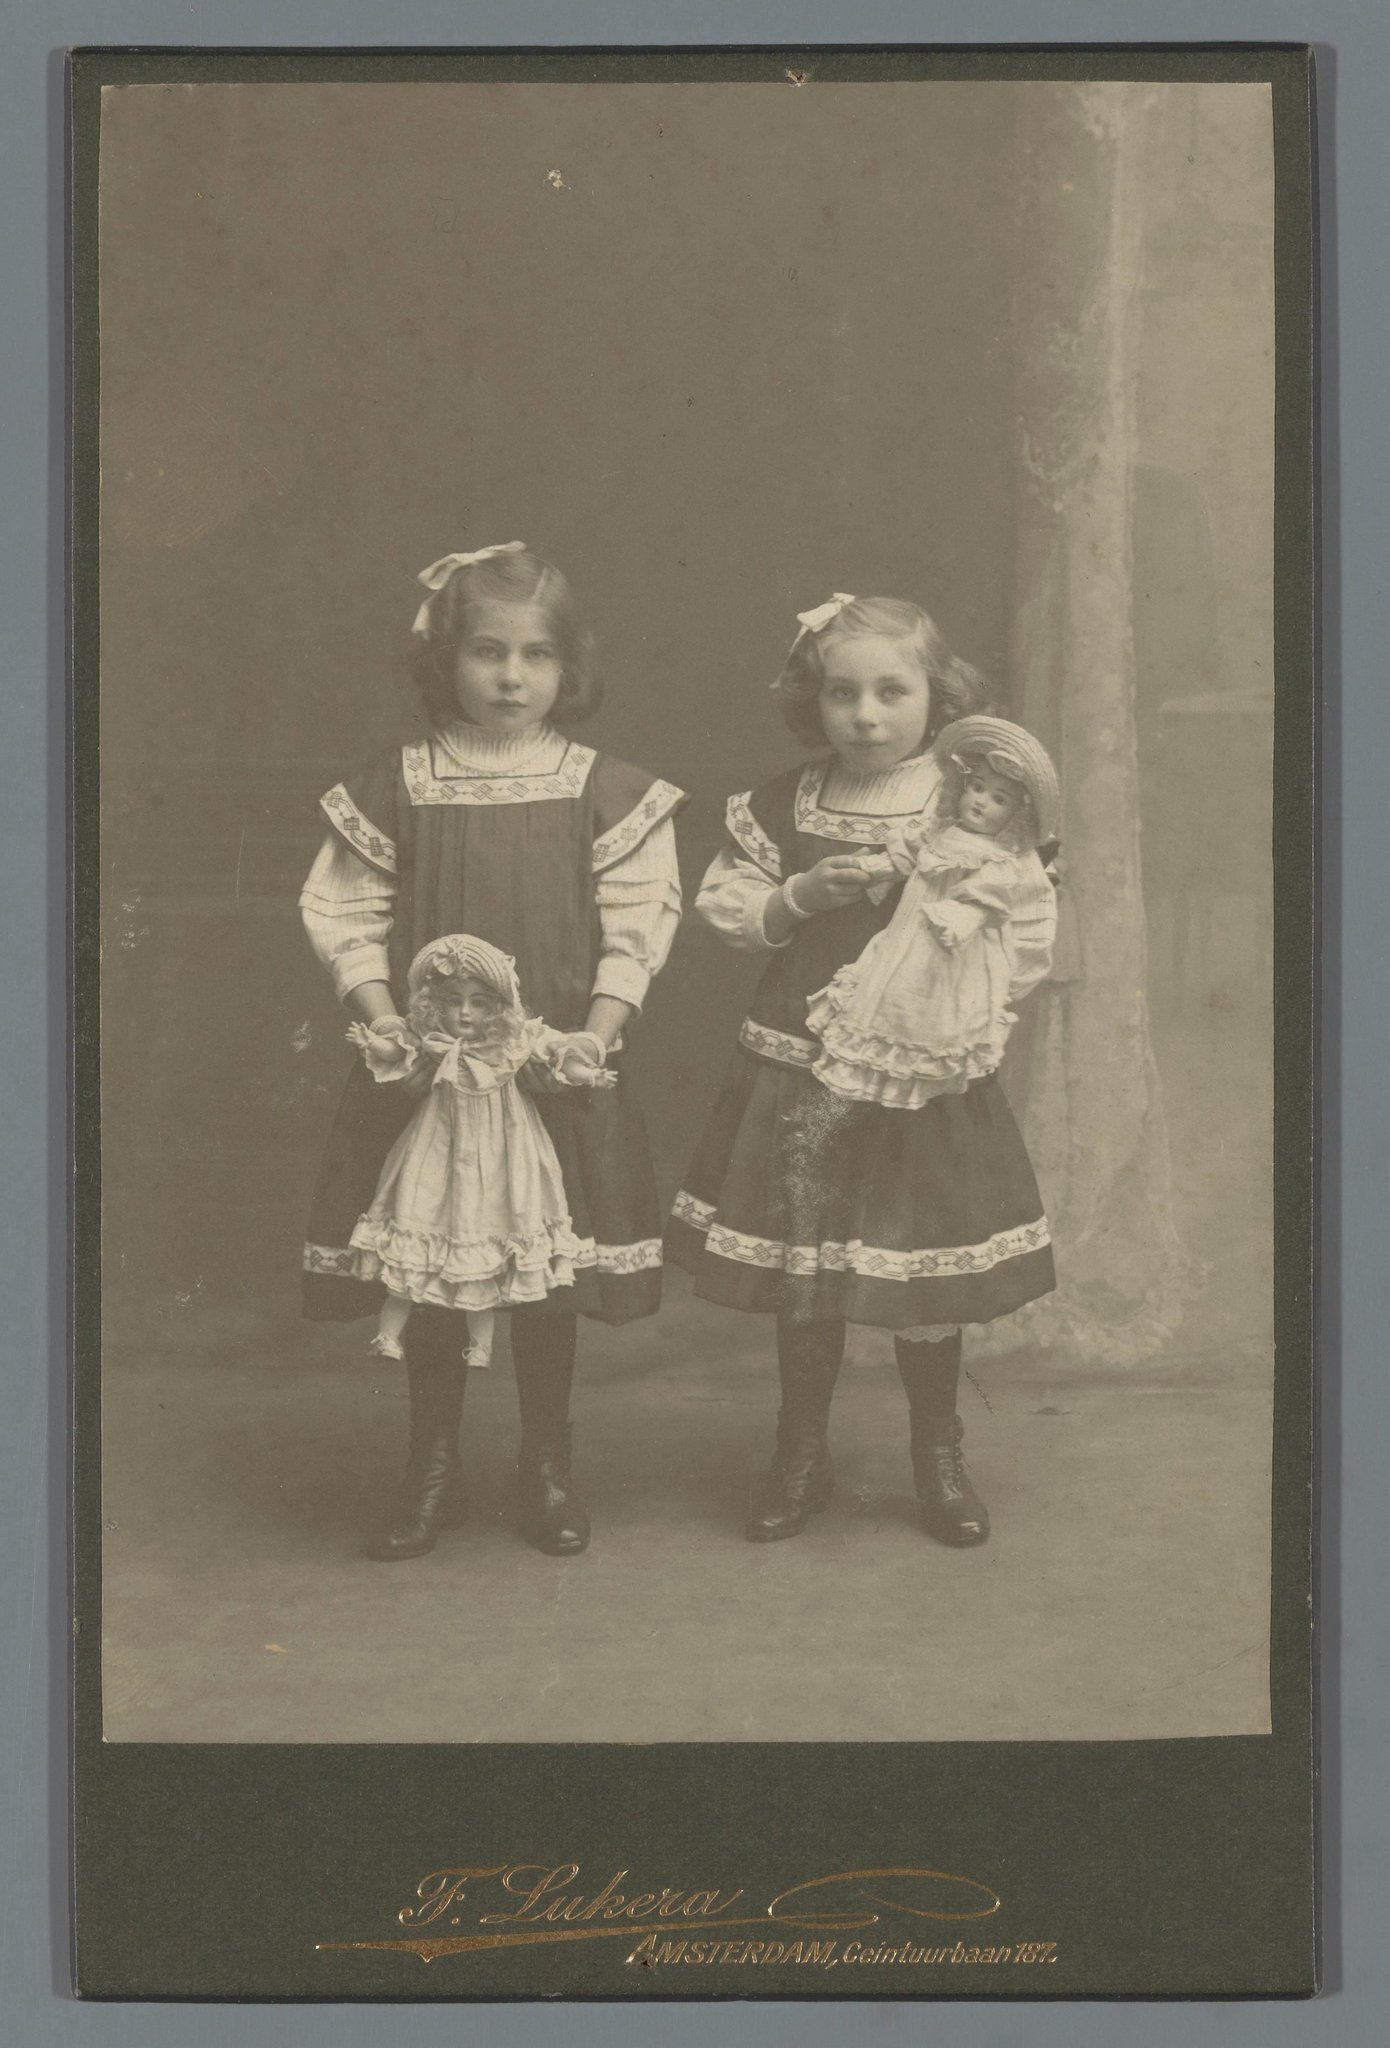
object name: photograph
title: Portret van twee onbekende meisjes met poppen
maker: franciscus g. lukera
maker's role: fotograaf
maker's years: 1853-1927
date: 1893-1927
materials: cardboard, photographic support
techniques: matte daylight collodion silver print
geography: amsterdam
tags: (playing with) dolls, child (at home) - aa - girl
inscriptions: name: ‘Atelier voor moderne Photografie F. Lukera Amsterdam, Ceintuurbaan 187 3e huis van de van Woustraat. Atelier parterre (...)’